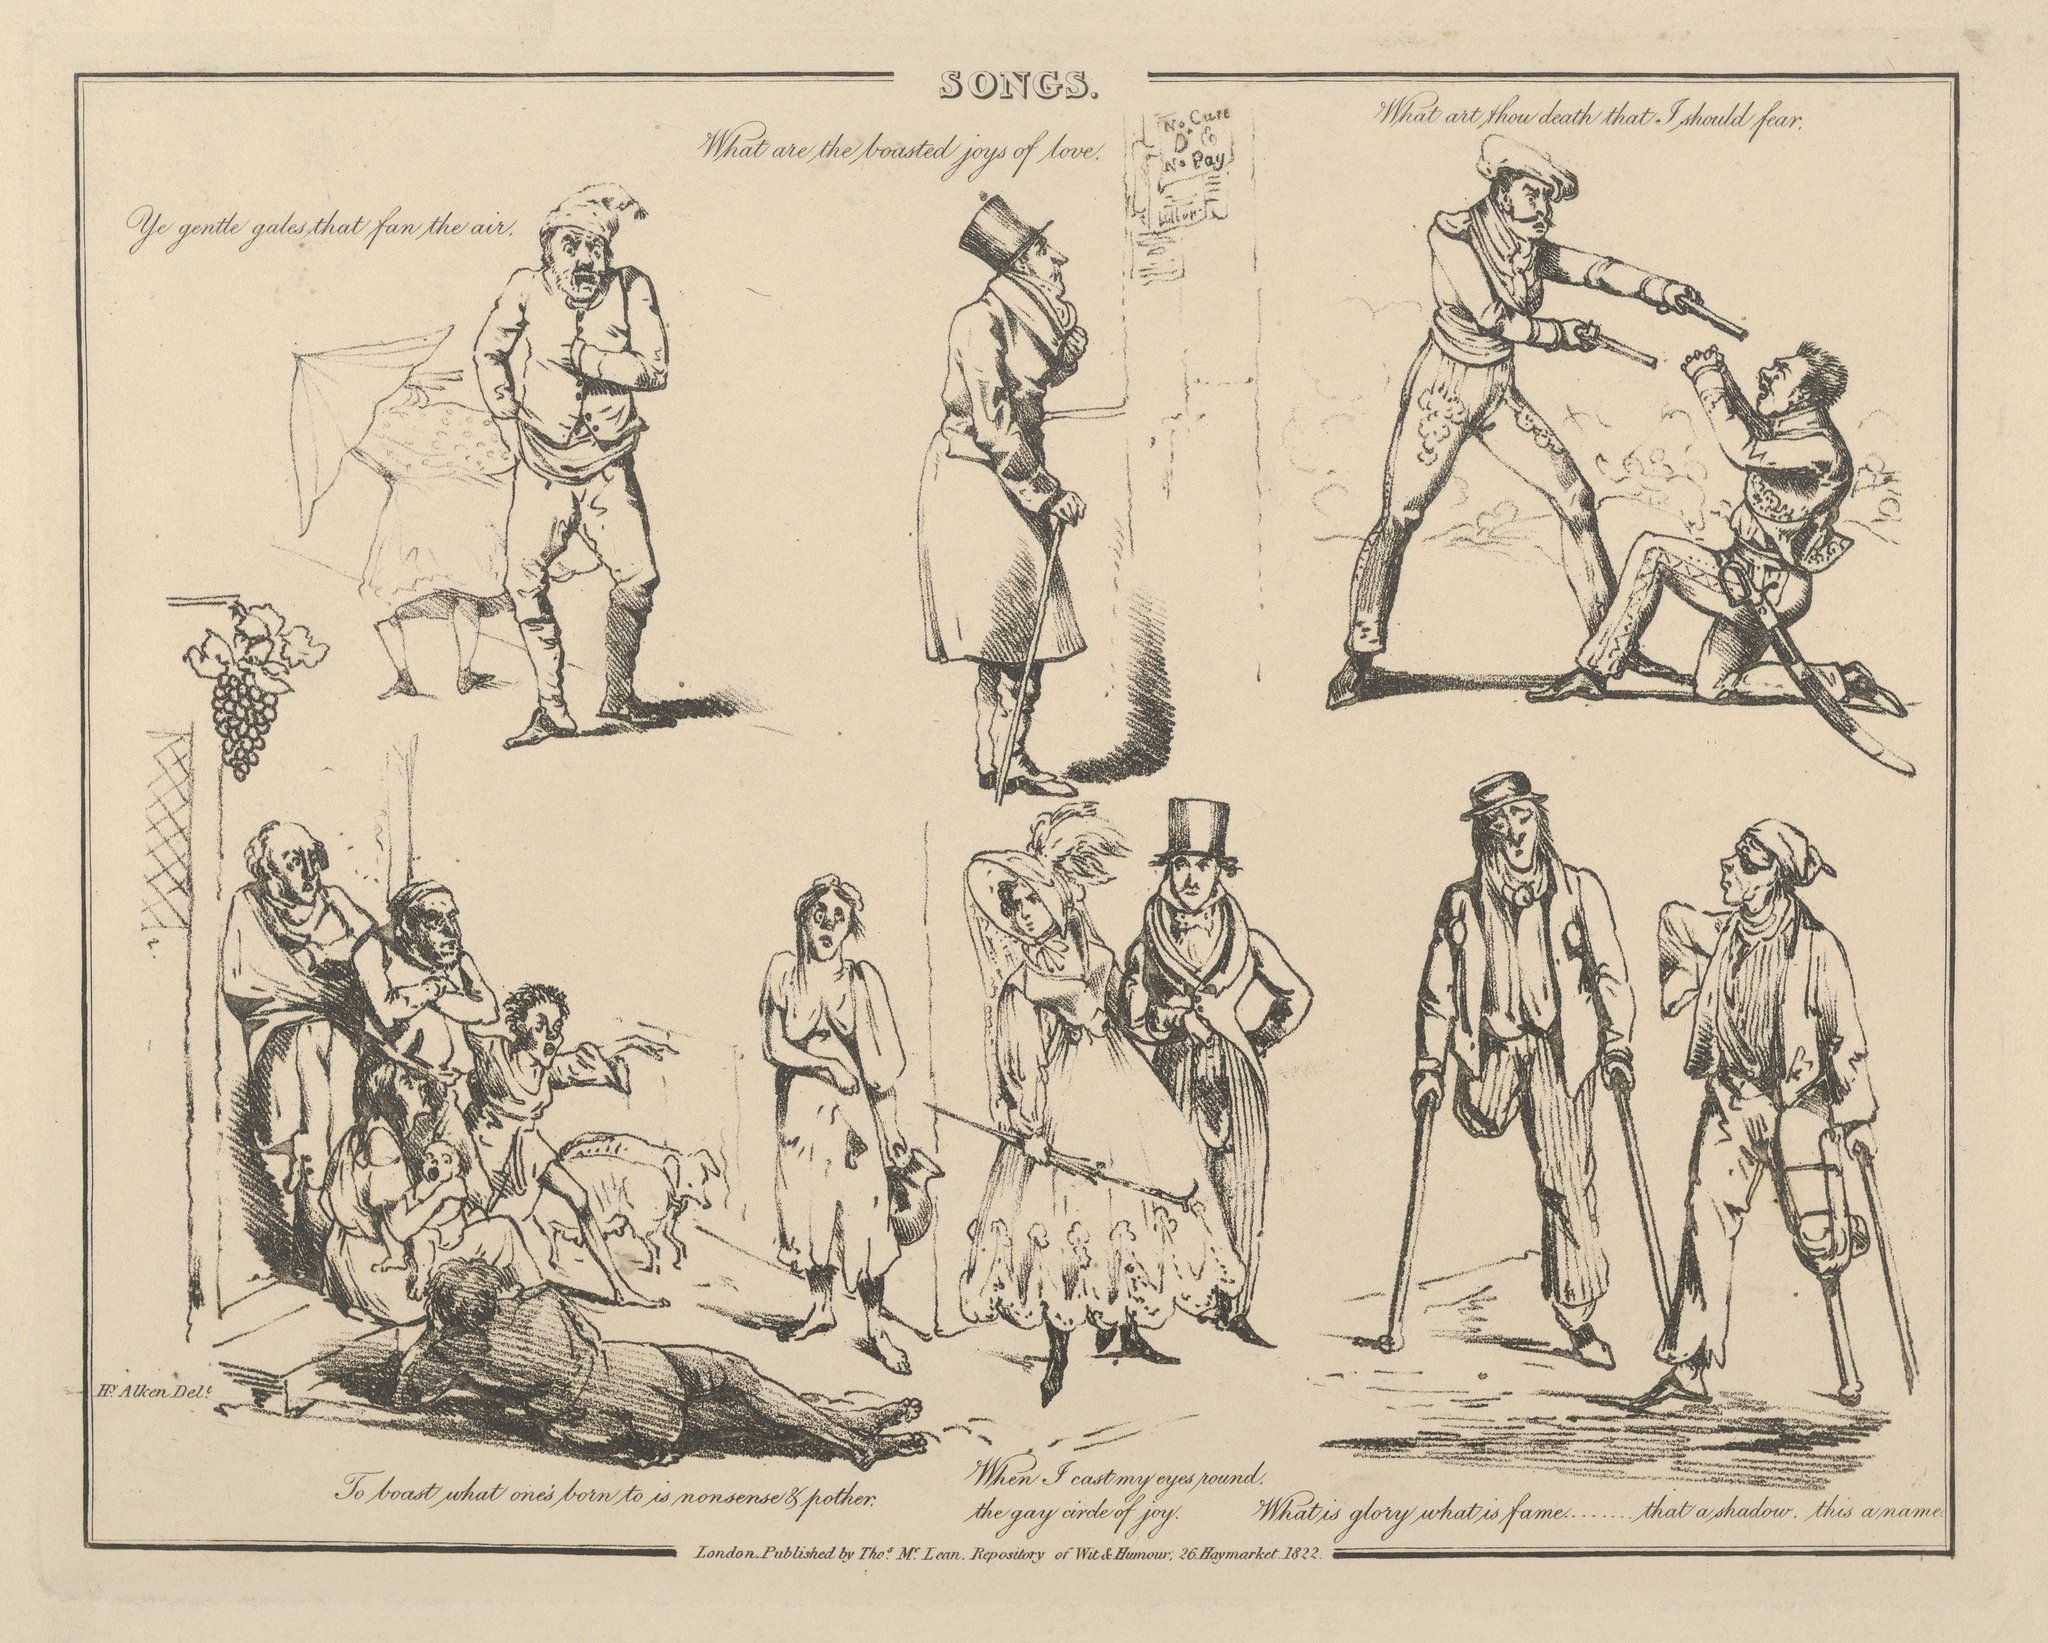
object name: print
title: Songs: "Ye gentle gates that fan the air..."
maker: henry alken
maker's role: artist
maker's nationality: british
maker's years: 1785-1851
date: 1822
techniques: etching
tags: satire,men,women